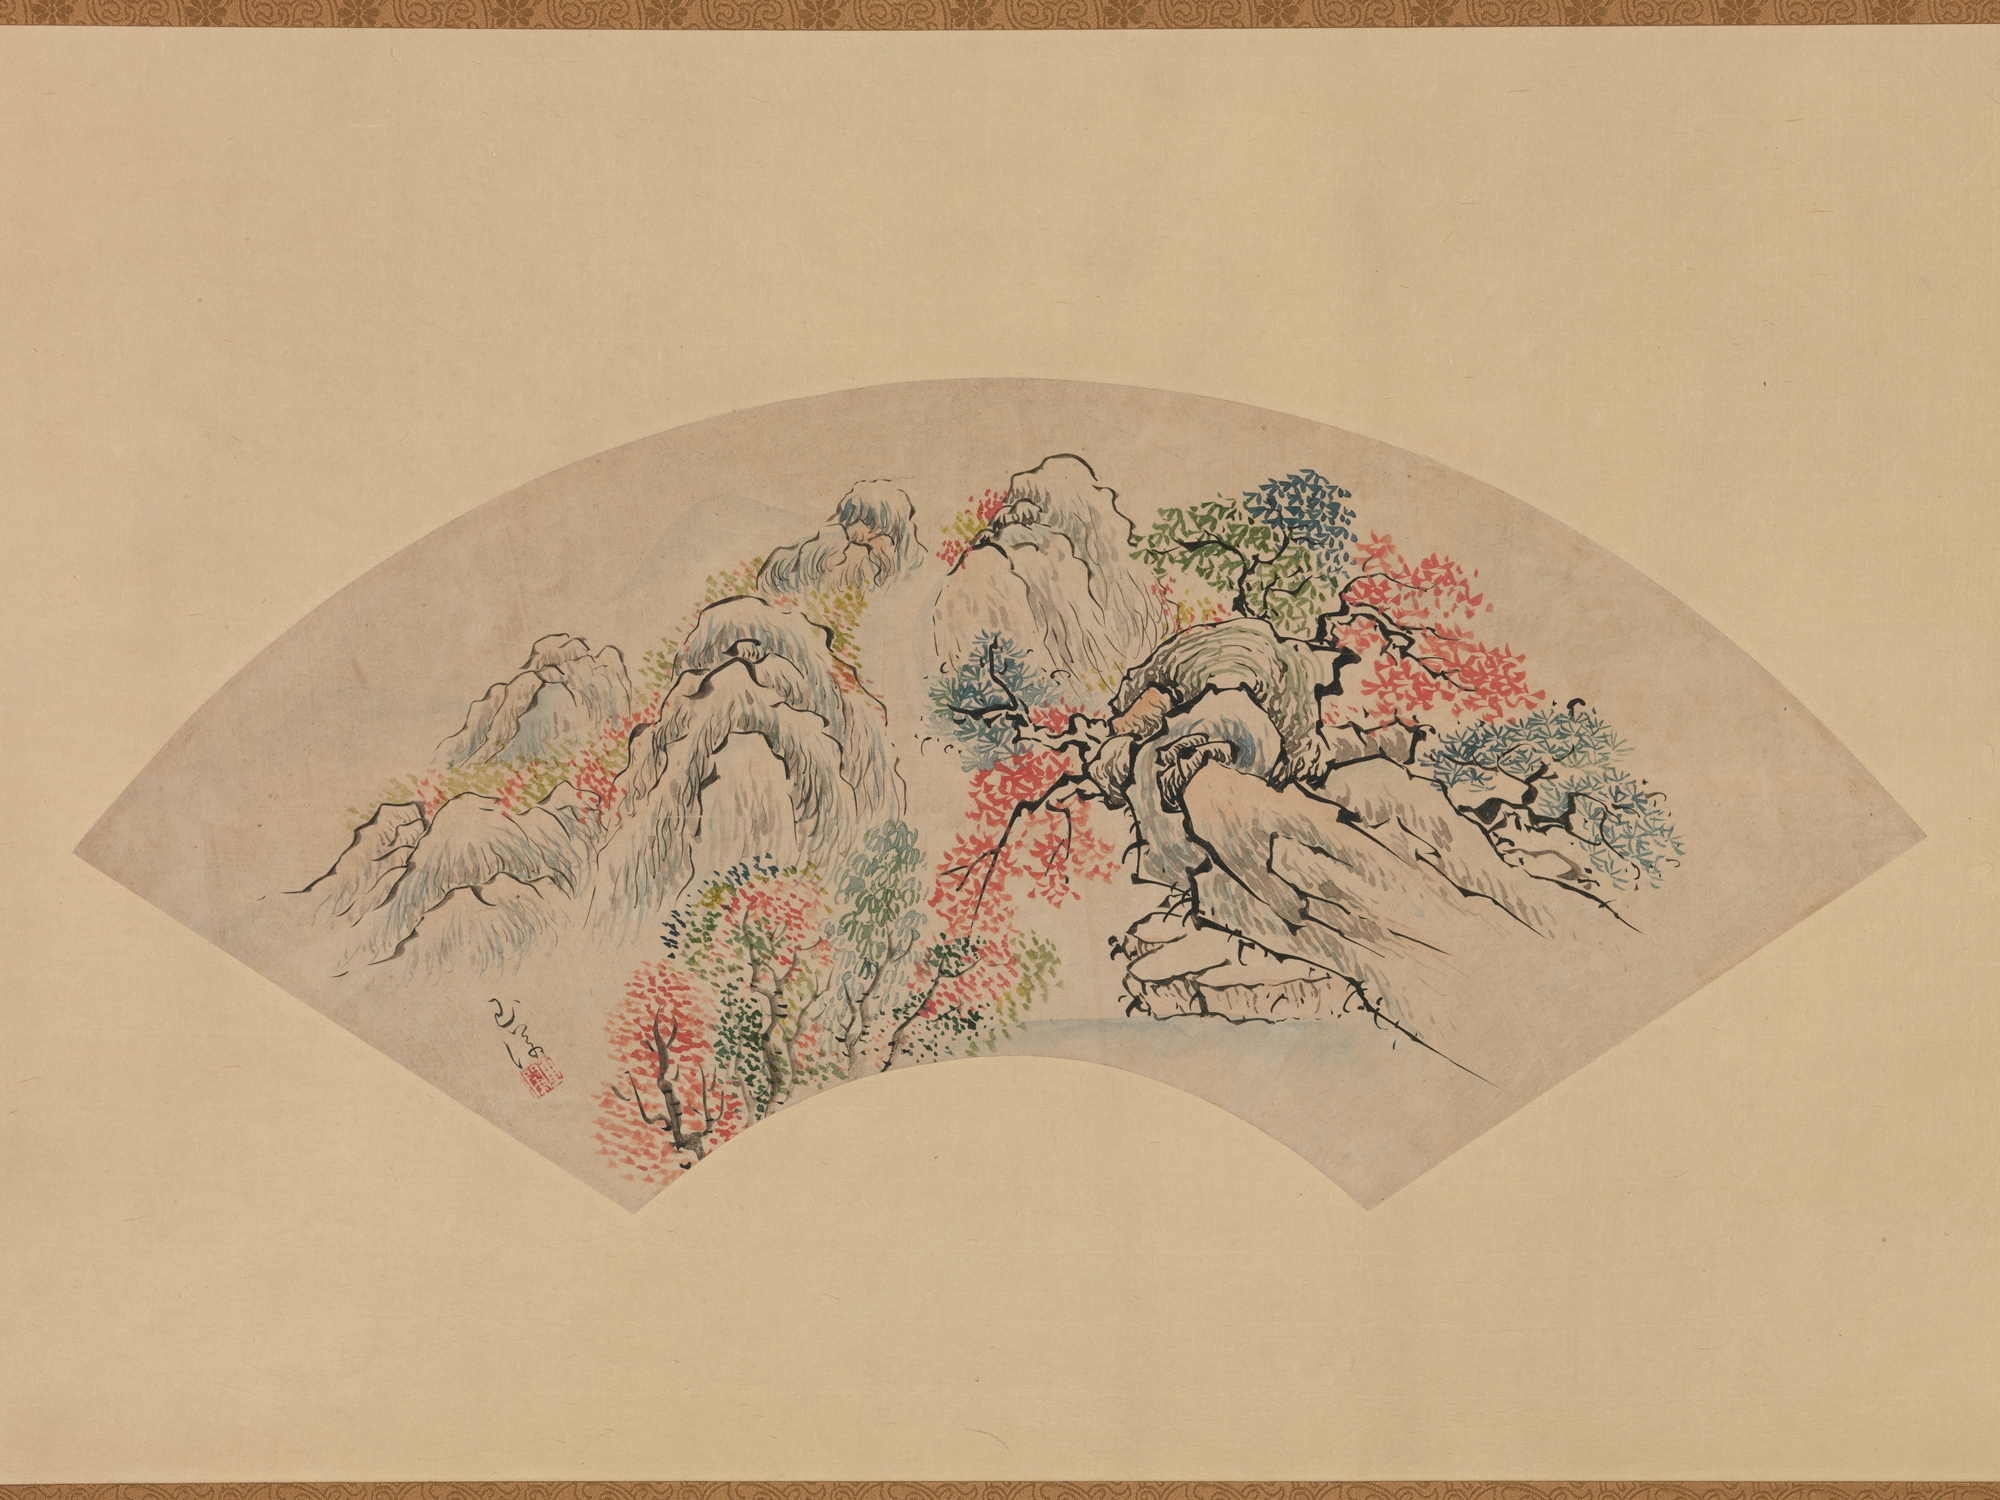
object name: hanging scroll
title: Autumnal Landscape with a Waterfall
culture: japanese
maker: ike (tokuyama) gyokuran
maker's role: artist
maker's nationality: japanese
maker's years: 1728-1784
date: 1751-1800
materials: ink, paper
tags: landscapes